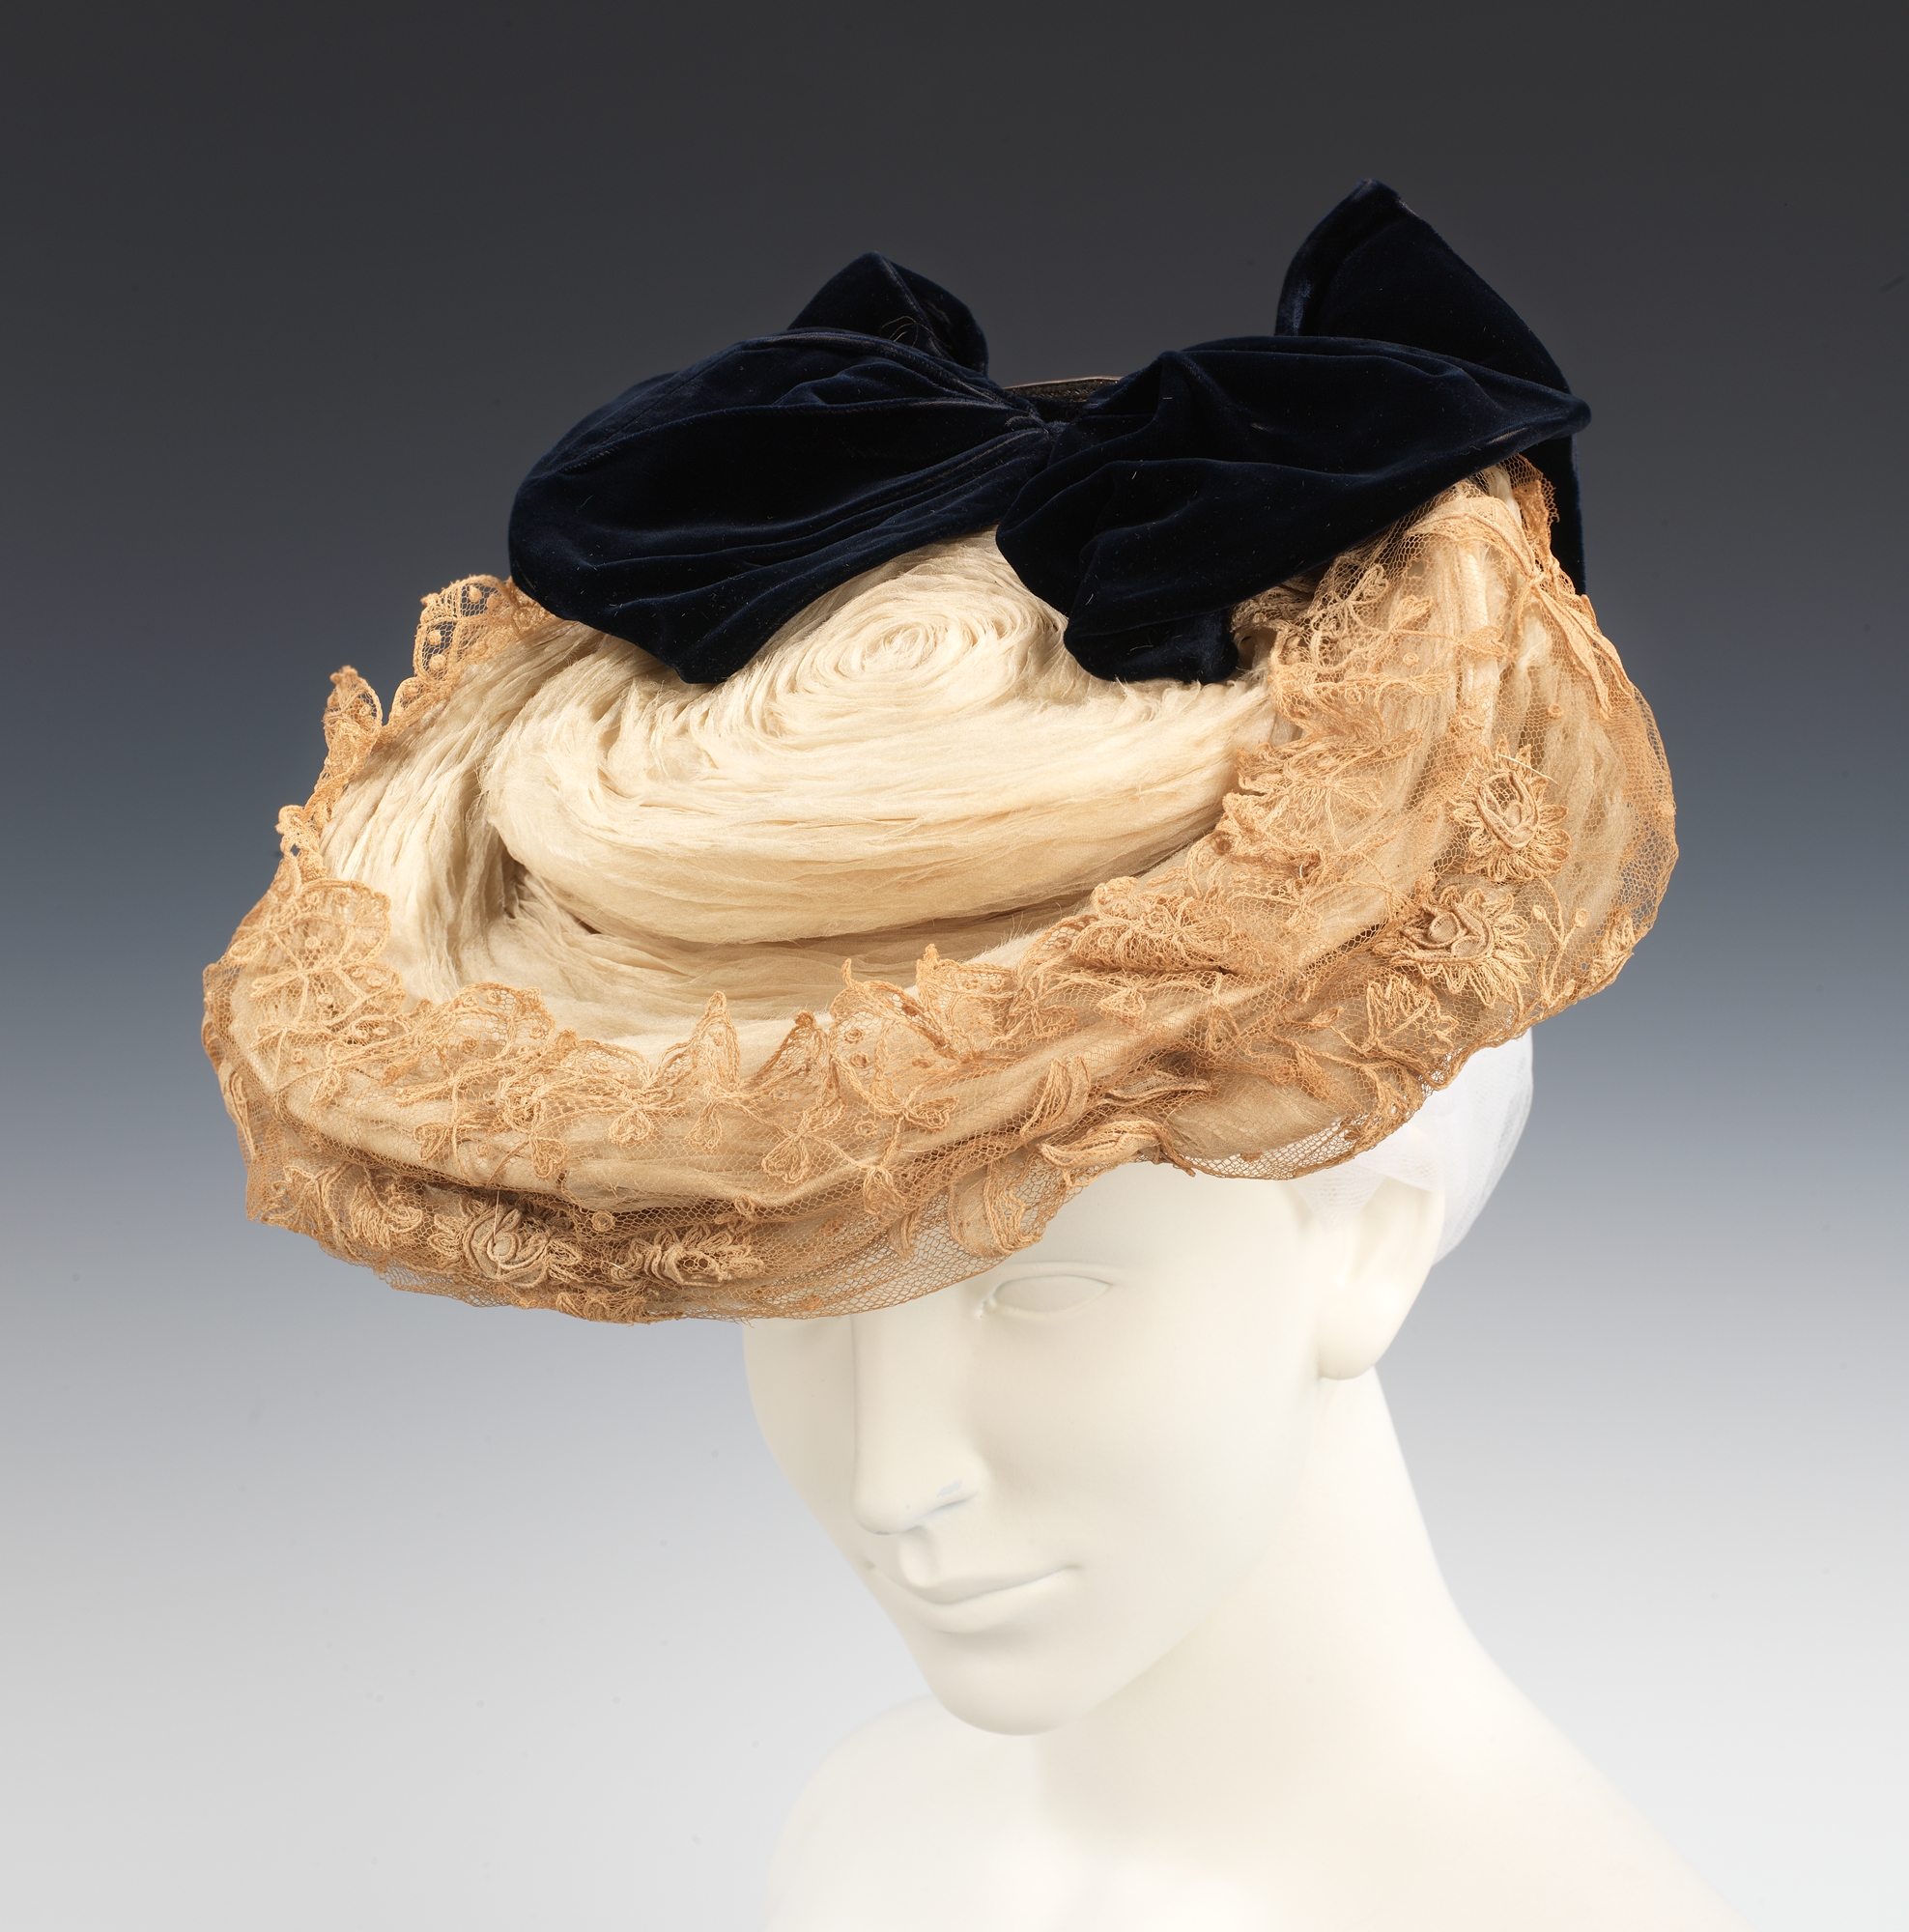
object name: hat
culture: french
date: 1898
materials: metal, silk